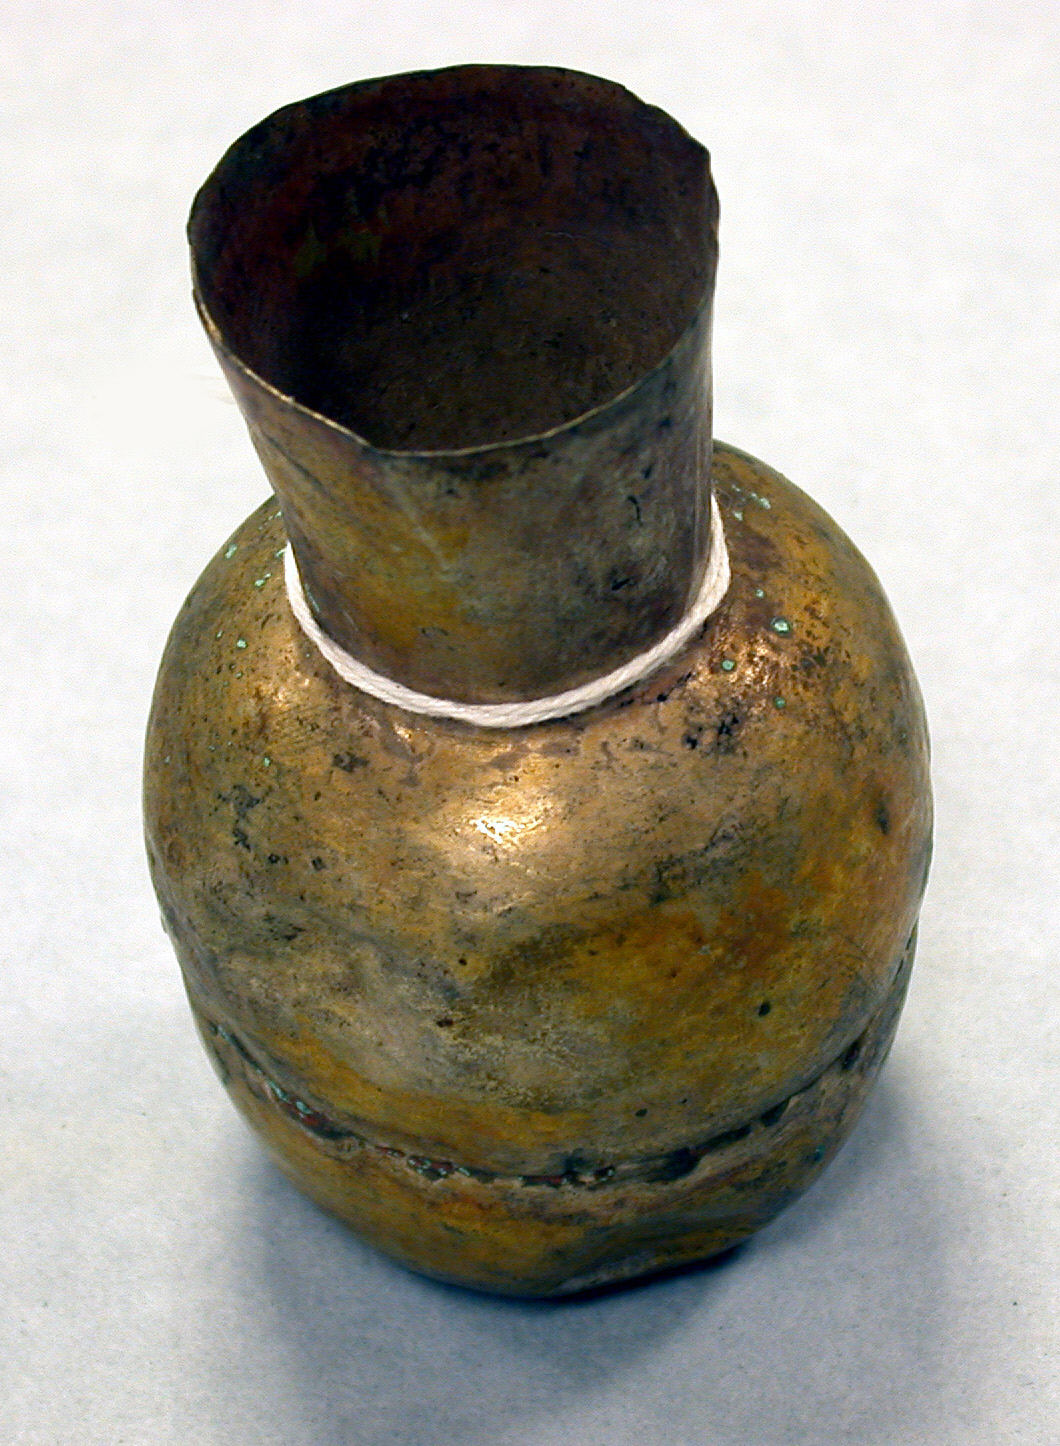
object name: bottle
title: Miniature Bottle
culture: chancay or chimú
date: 1001-1500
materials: gilt, silver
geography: peru